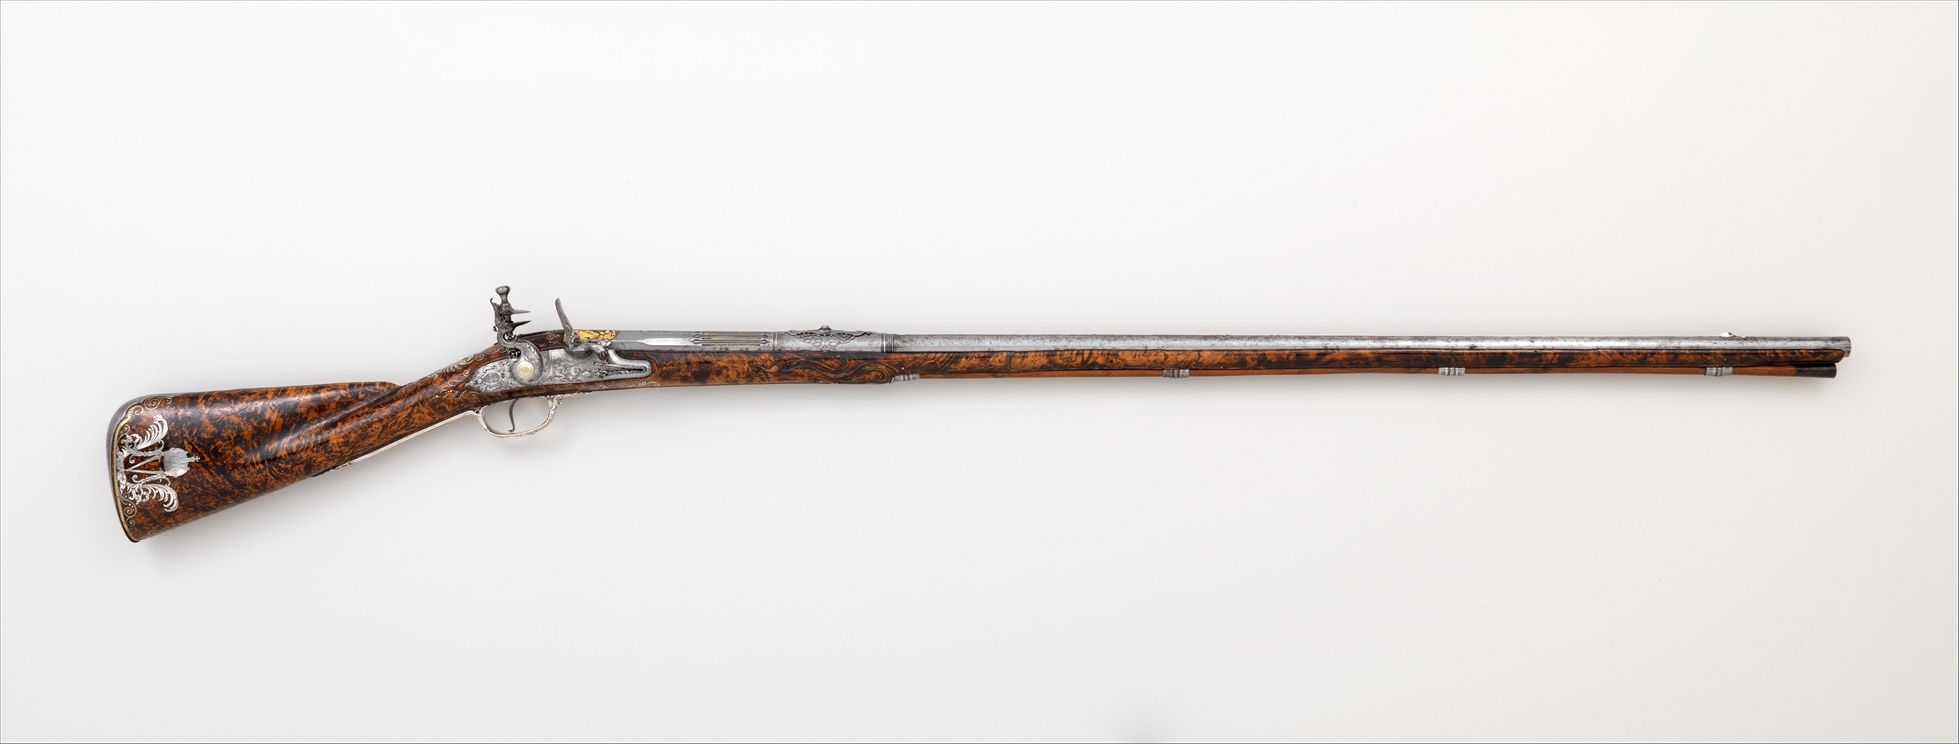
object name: flintlock pistol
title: Flintlock Sporting Gun of Empress Margarita Teresa of Spain (1651–1673)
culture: austrian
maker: jacques lamarre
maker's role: gunsmith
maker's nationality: french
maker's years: 1657-1700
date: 1670-1673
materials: copper alloy, gold, silver, steel, wood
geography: austria